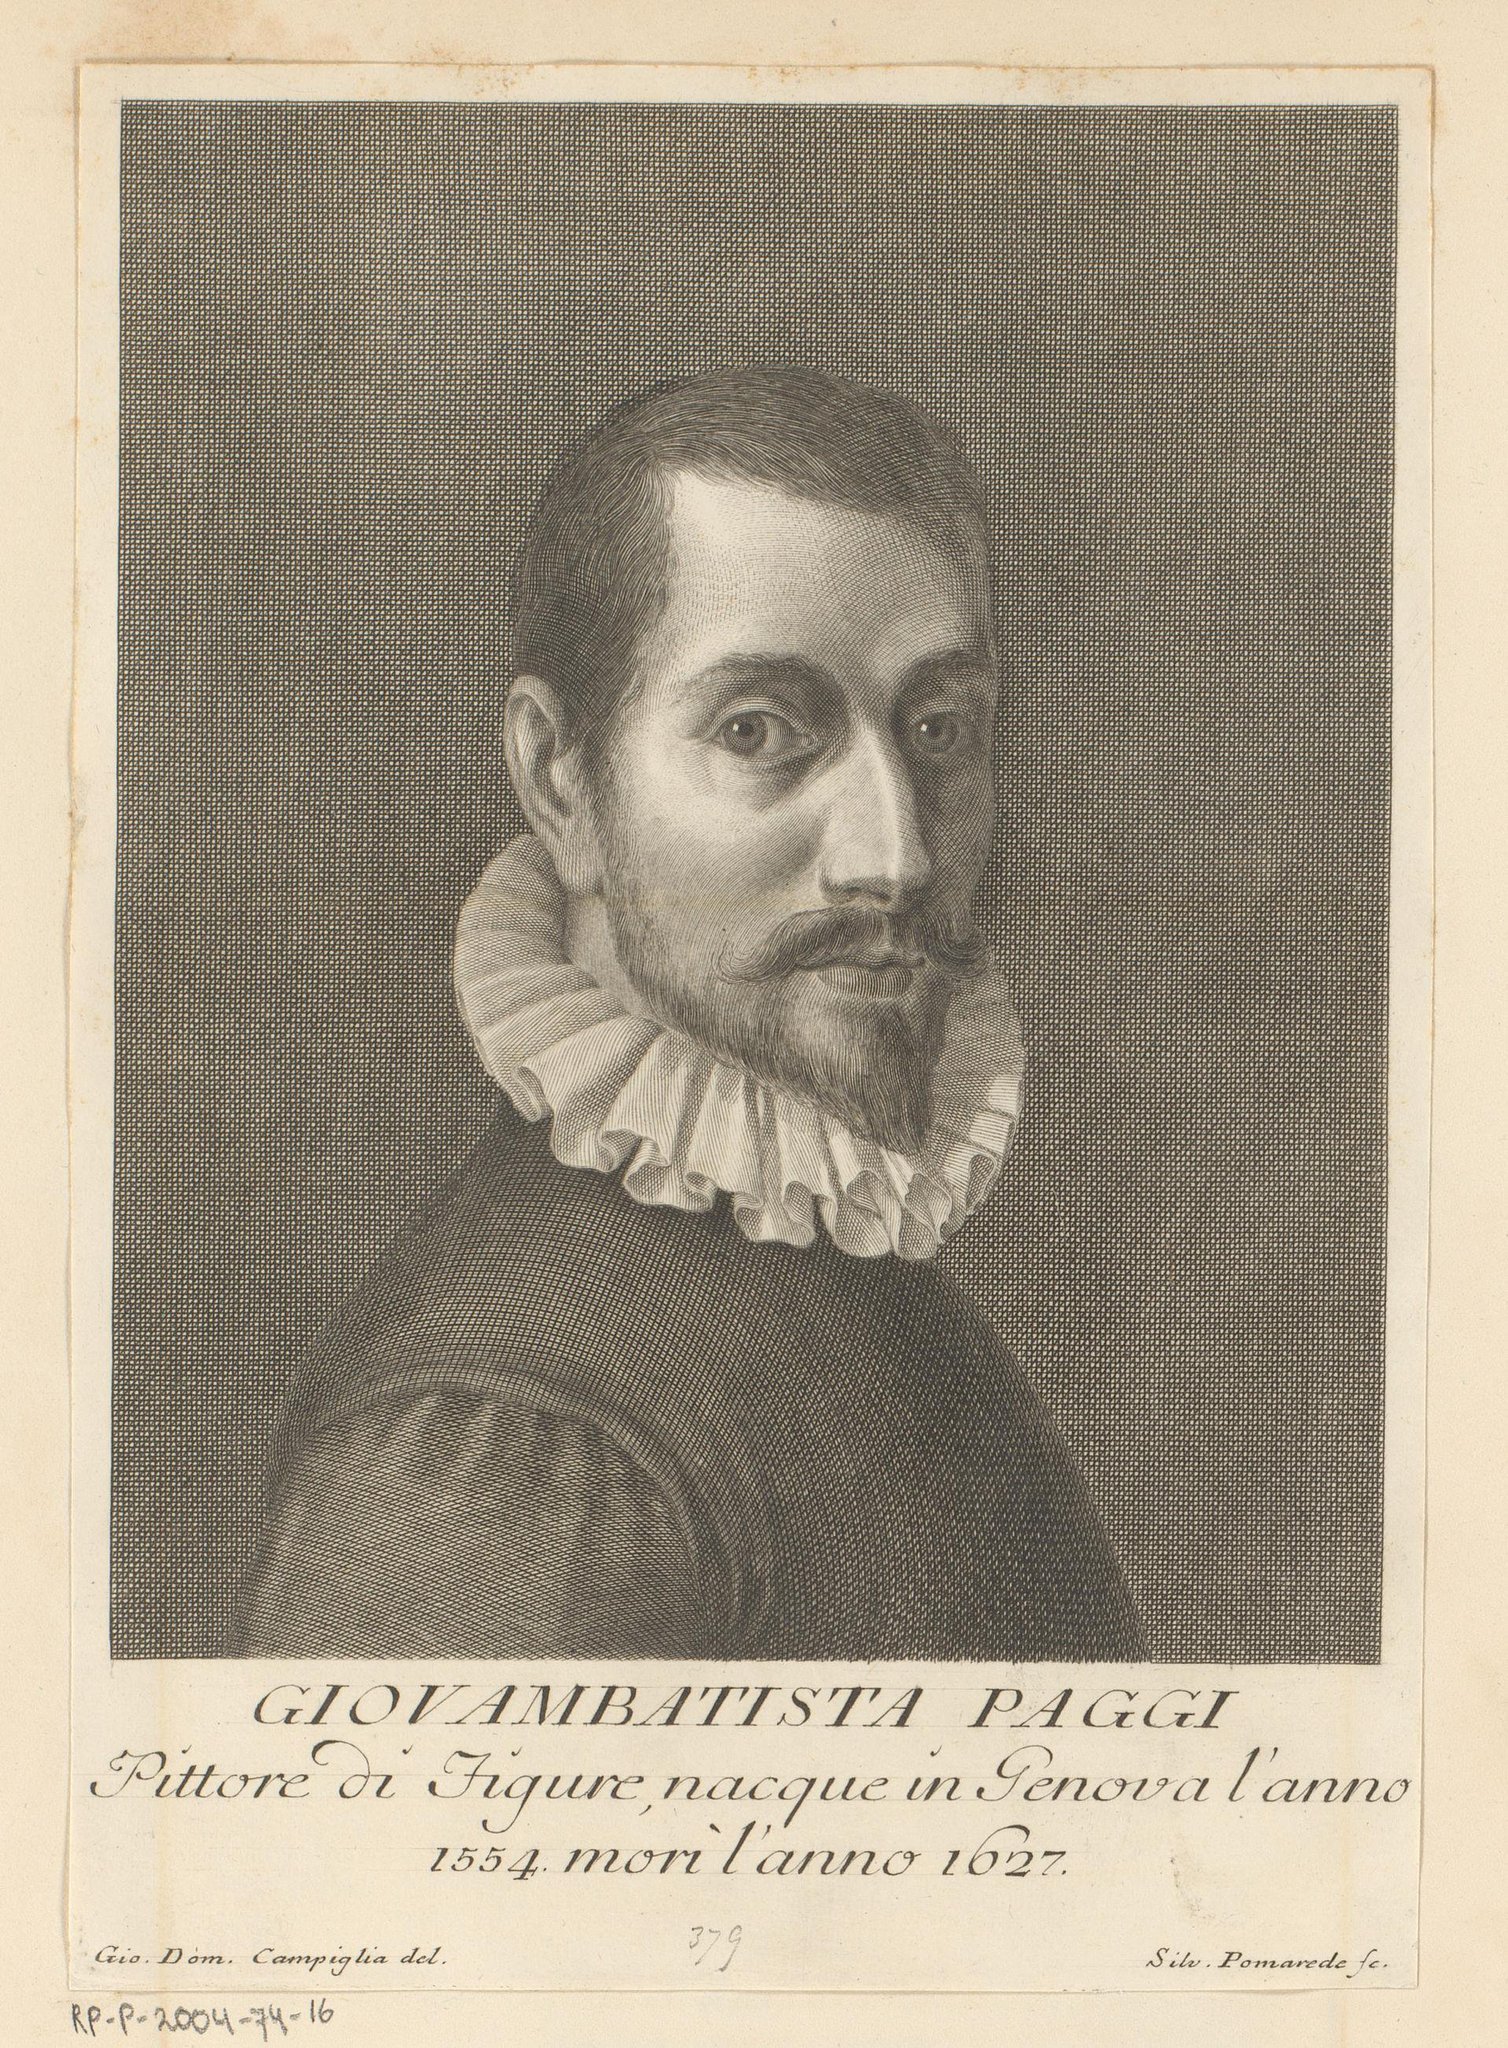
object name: album leaf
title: Florentijns museum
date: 1752-1766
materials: paper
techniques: engraving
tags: draughtsman, giovanni battista paggi, historical persons, portrait, self-portrait of painter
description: Prent is onderdeel van een serie getiteld 'Museum Florentinum', bestaande uit vier subsecties: 'Gemmae antiquae ex Thesauro Mediceo et privatorum dactyliothecis florentiae...' (1730-1731), 'Statuae antiquae dorum et virorum illustrium' (1734), 'Antiqua numismata aurea et argentea' (1740-1741) en 'Serie di ritratti degli eccellenti pittori' (1752-1766). Het vierde deel bestaat uit 320 kunstenaarsportretten en is uitgegeven in boekvorm (vier delen). Andere staat gebruikt in: Moücke, Francesco. Serie di ritratti degli eccellenti pittori : dipinti di propria mano che esistono nell'Imperial galleria di Firenze. 4 dln. Florence: Francesco Moücke, 1753, dl. 1, p. 244. De samensteller heeft deze prent in het album geplakt als illustratie bij: Pilkington, Matthew en Johann Heinrich Füssli. A dictionary of painters, from the revival of the art to the present period. 4 dln. Londen: John Crowder, 1805, dl. 3, p. 379.